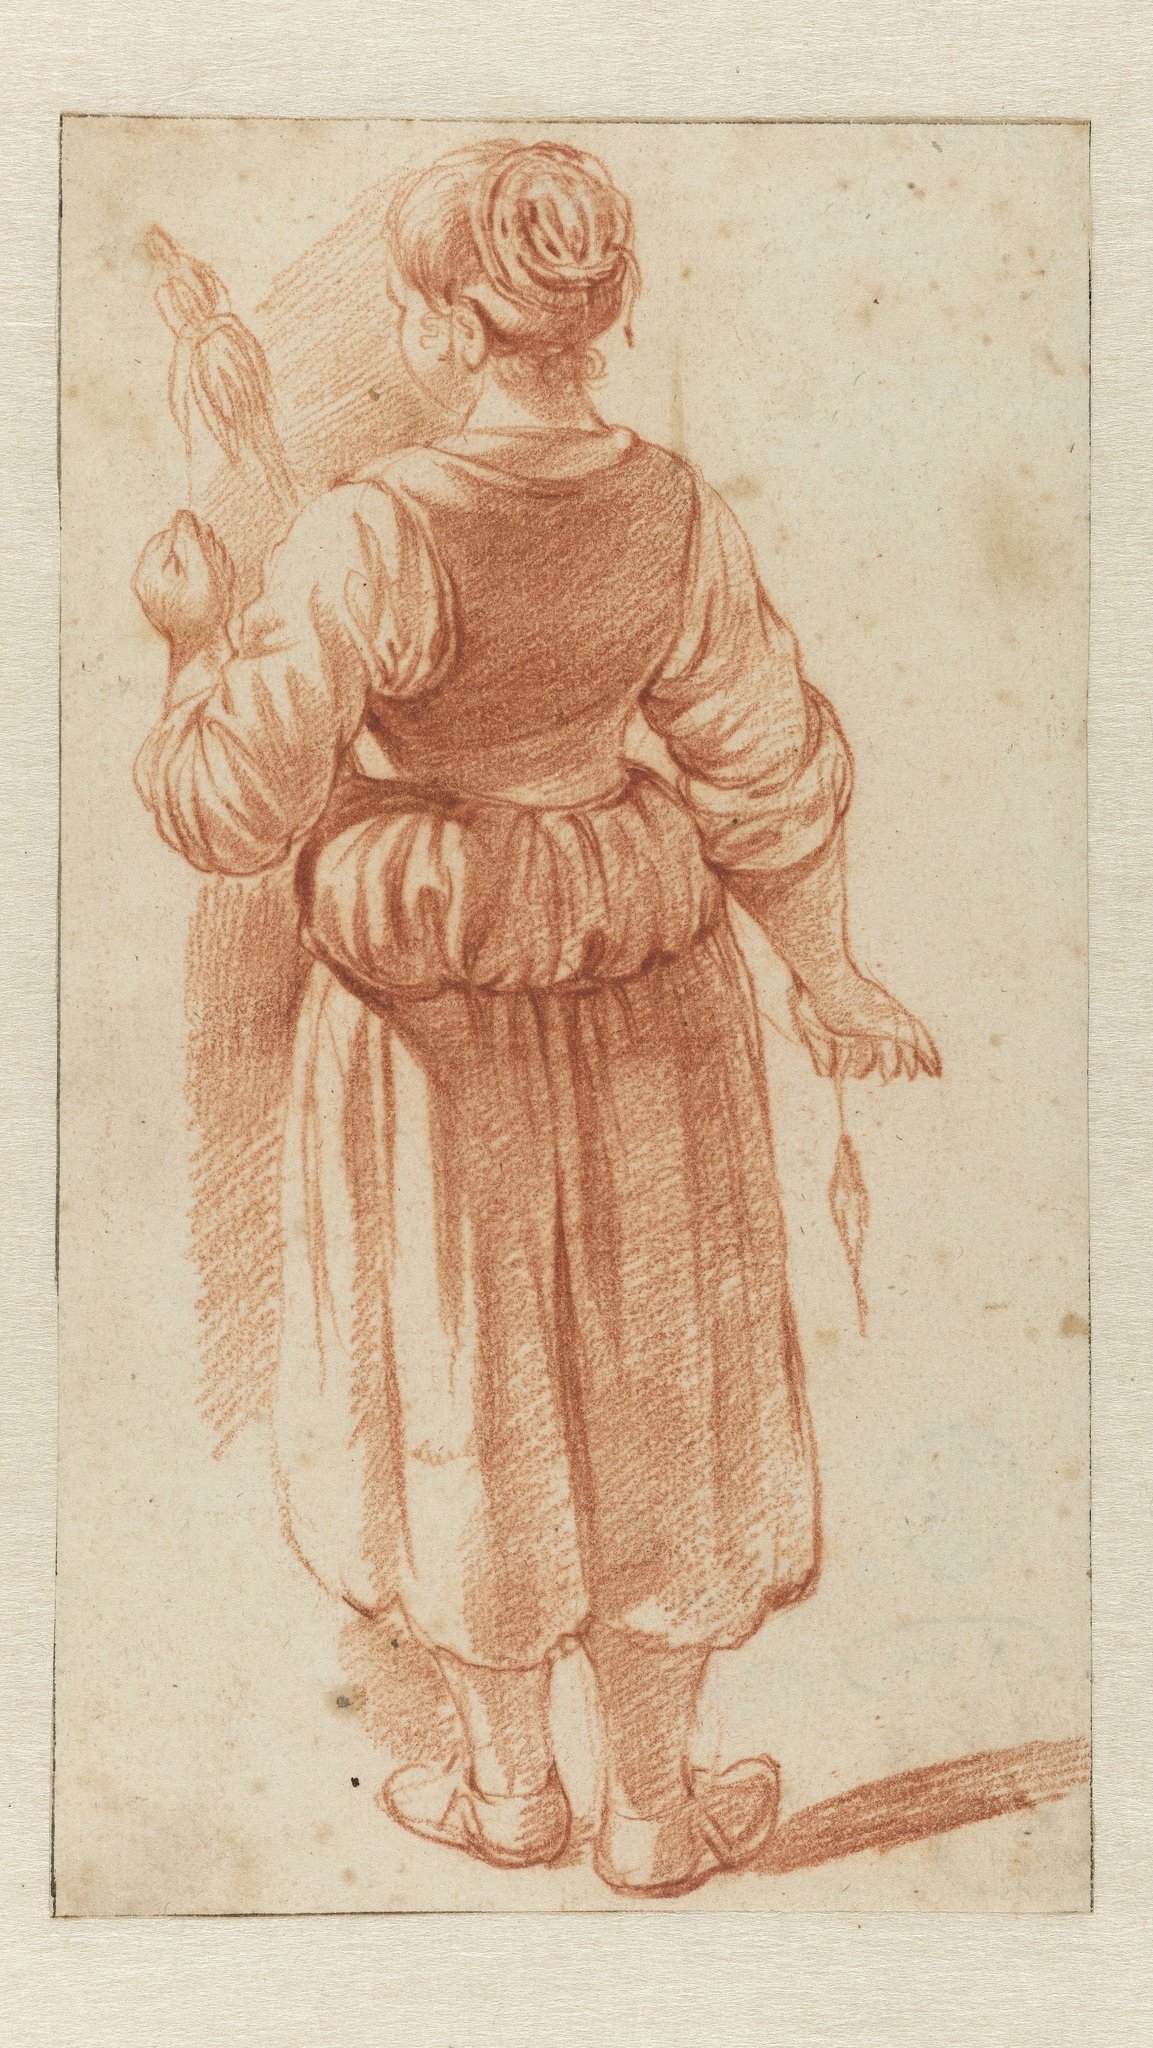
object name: drawing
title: Spinnende vrouw, staand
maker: adriaen van de velde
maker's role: draughtsman, painter, print maker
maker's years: 1636-1672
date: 1646-1672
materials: chalk, paper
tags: standing figure - aa - female human figure, spinning (manufacture of yarn)